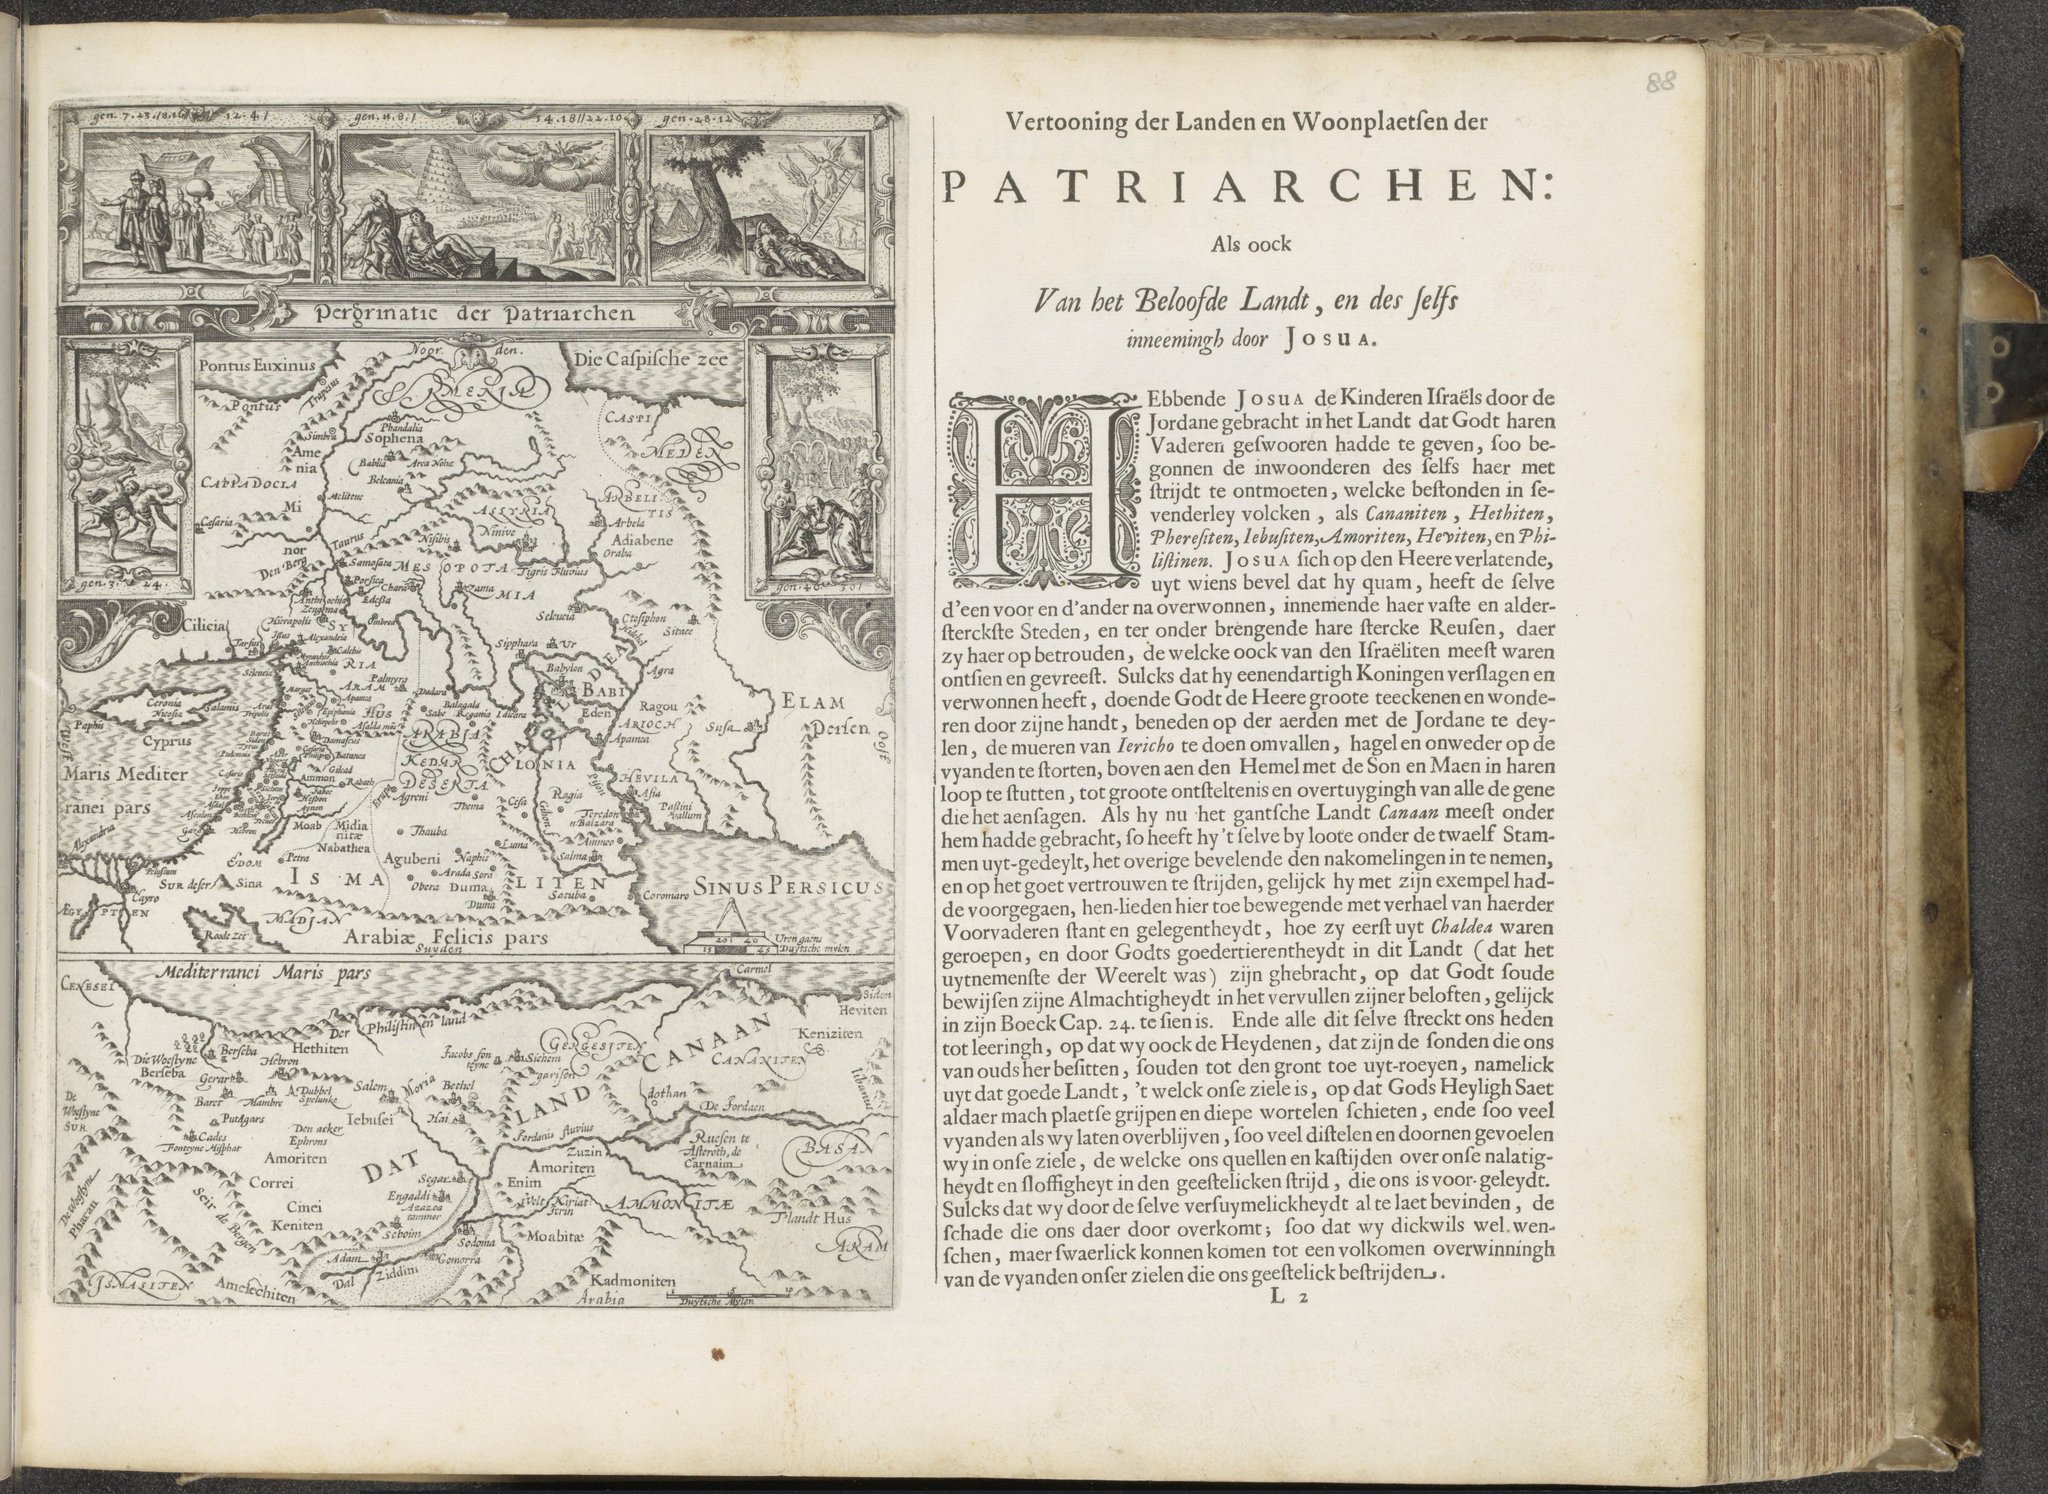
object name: map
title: Pergrinatie der Patriarchen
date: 1598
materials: paper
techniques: engraving, etching, letterpress printing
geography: amsterdam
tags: the ark ~ story of noah, the meeting of jacob and joseph in goshen, maps of separate countries or regions, the meeting of abraham and melchizedek, the high priest and king of salem, who brings bread and wine (genesis 14:18-20), the sacrifice of isaac (genesis 22), initial, the tower of babel, expulsion of adam and eve from paradise (genesis 3:22-24), old testament, the dream of jacob: while sleeping on the ground with a stone for pillow jacob sees a ladder reaching from earth to heaven with angels going up and down; usually with god at the top of the ladder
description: De kaart komt ook voor in: Den bybel, dat is De boecken der heyligher Schriftuer, Schotlandt by Danswĳck: K. Vermeulen de jonge, 1598